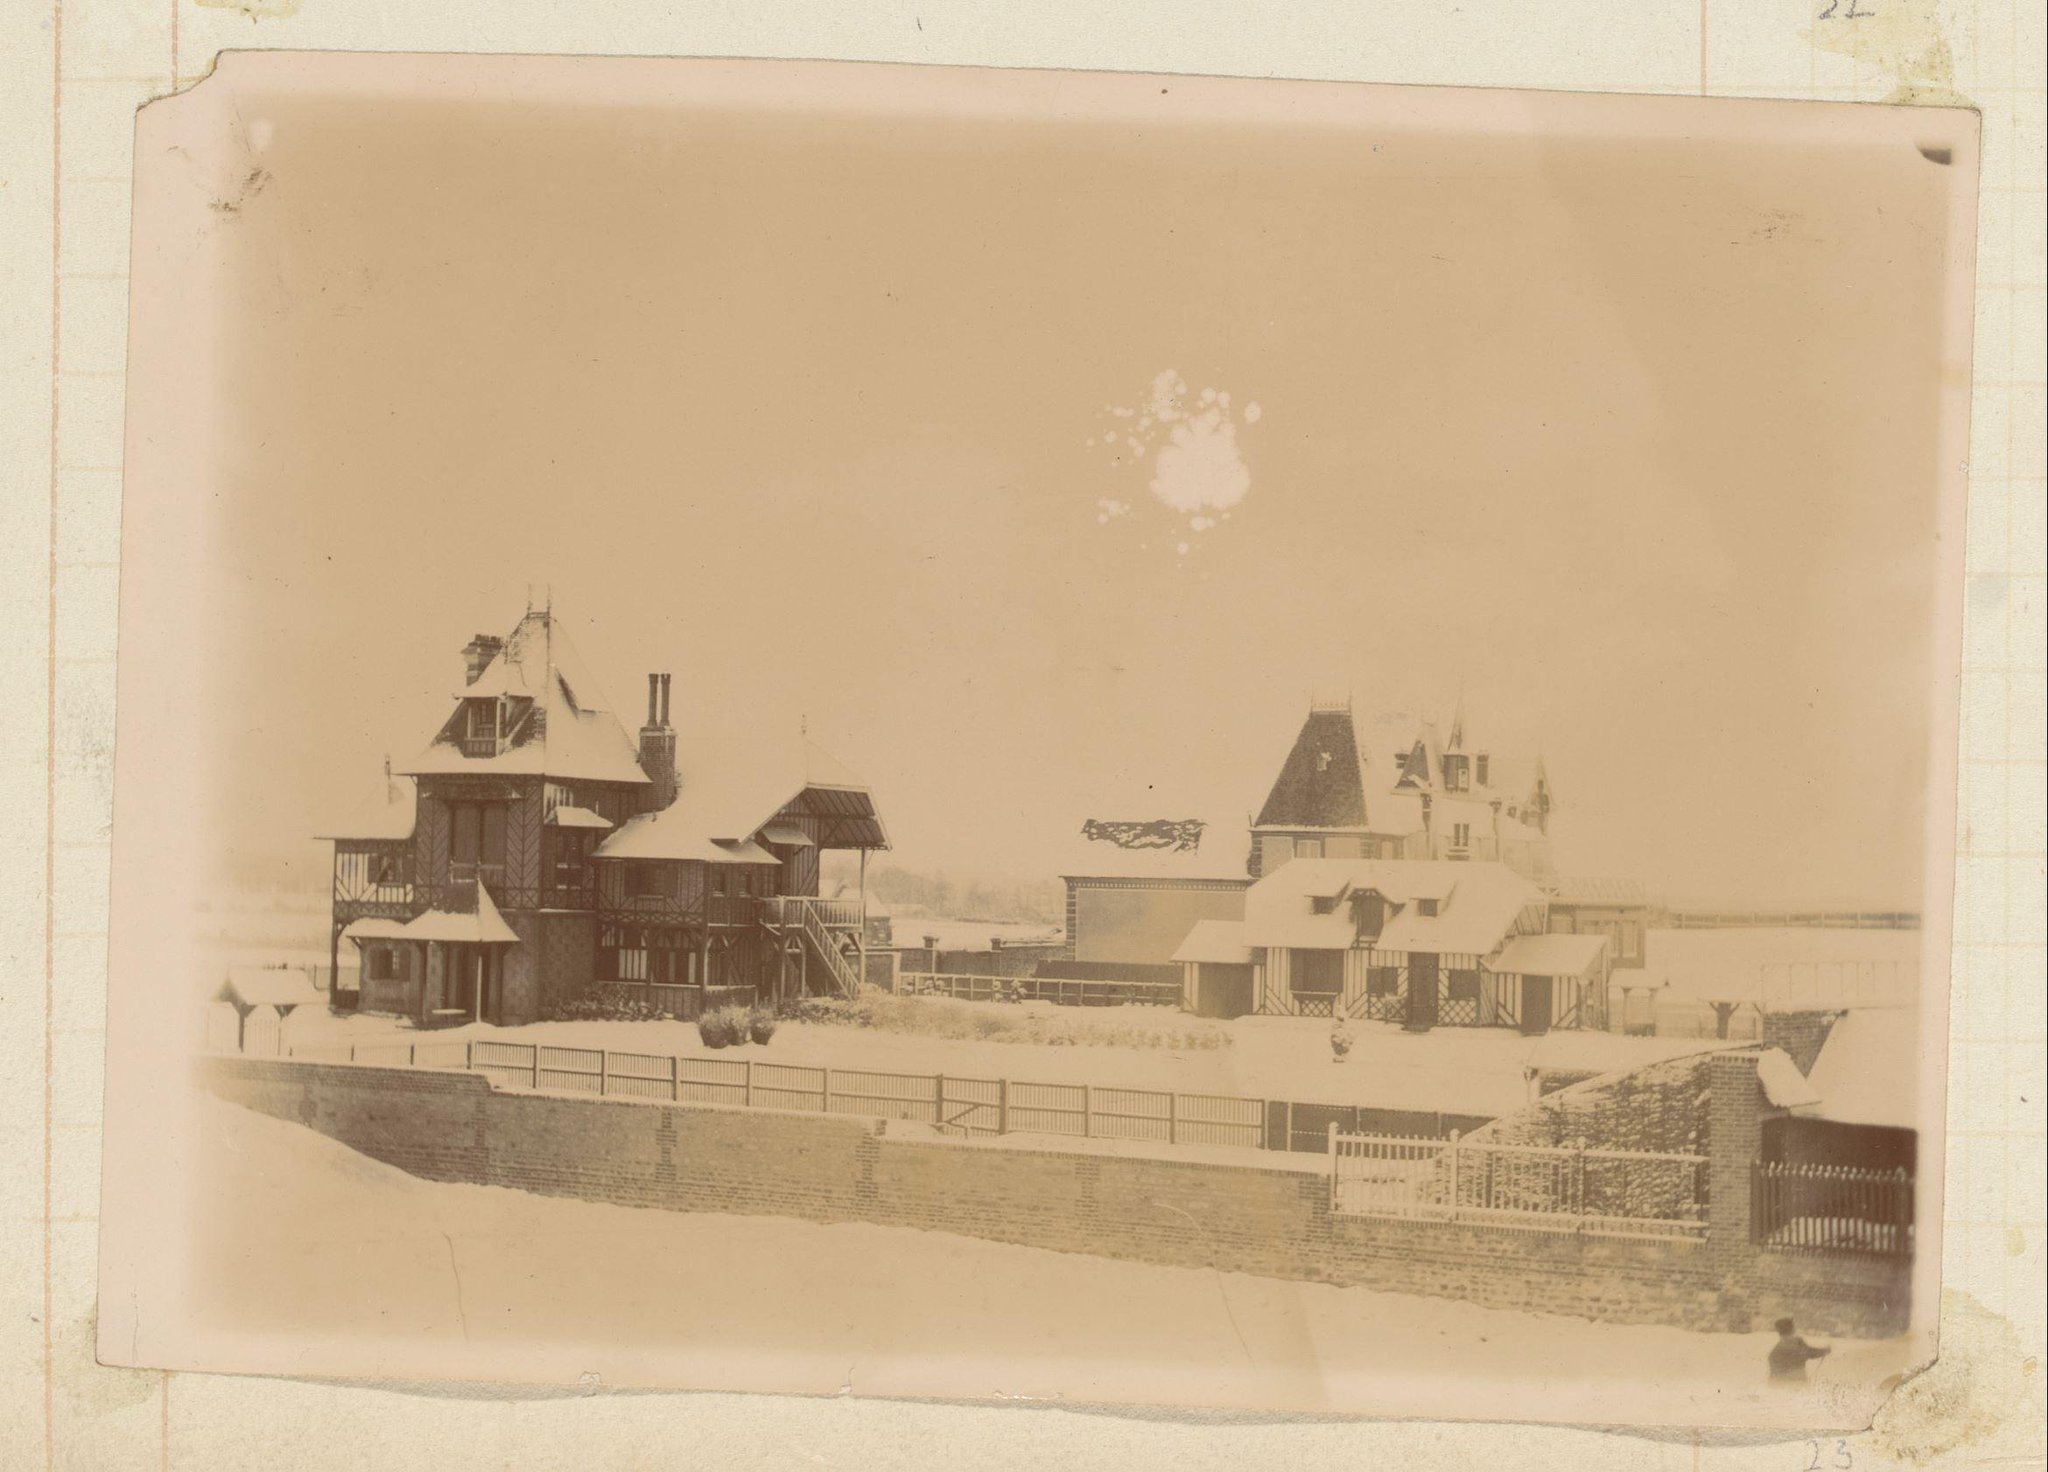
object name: photograph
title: Ommuurd complex van vakwerkhuizen in de sneeuw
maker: Anonymous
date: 1880-1900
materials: paper, photographic support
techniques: gelatin silver print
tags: villa, snow